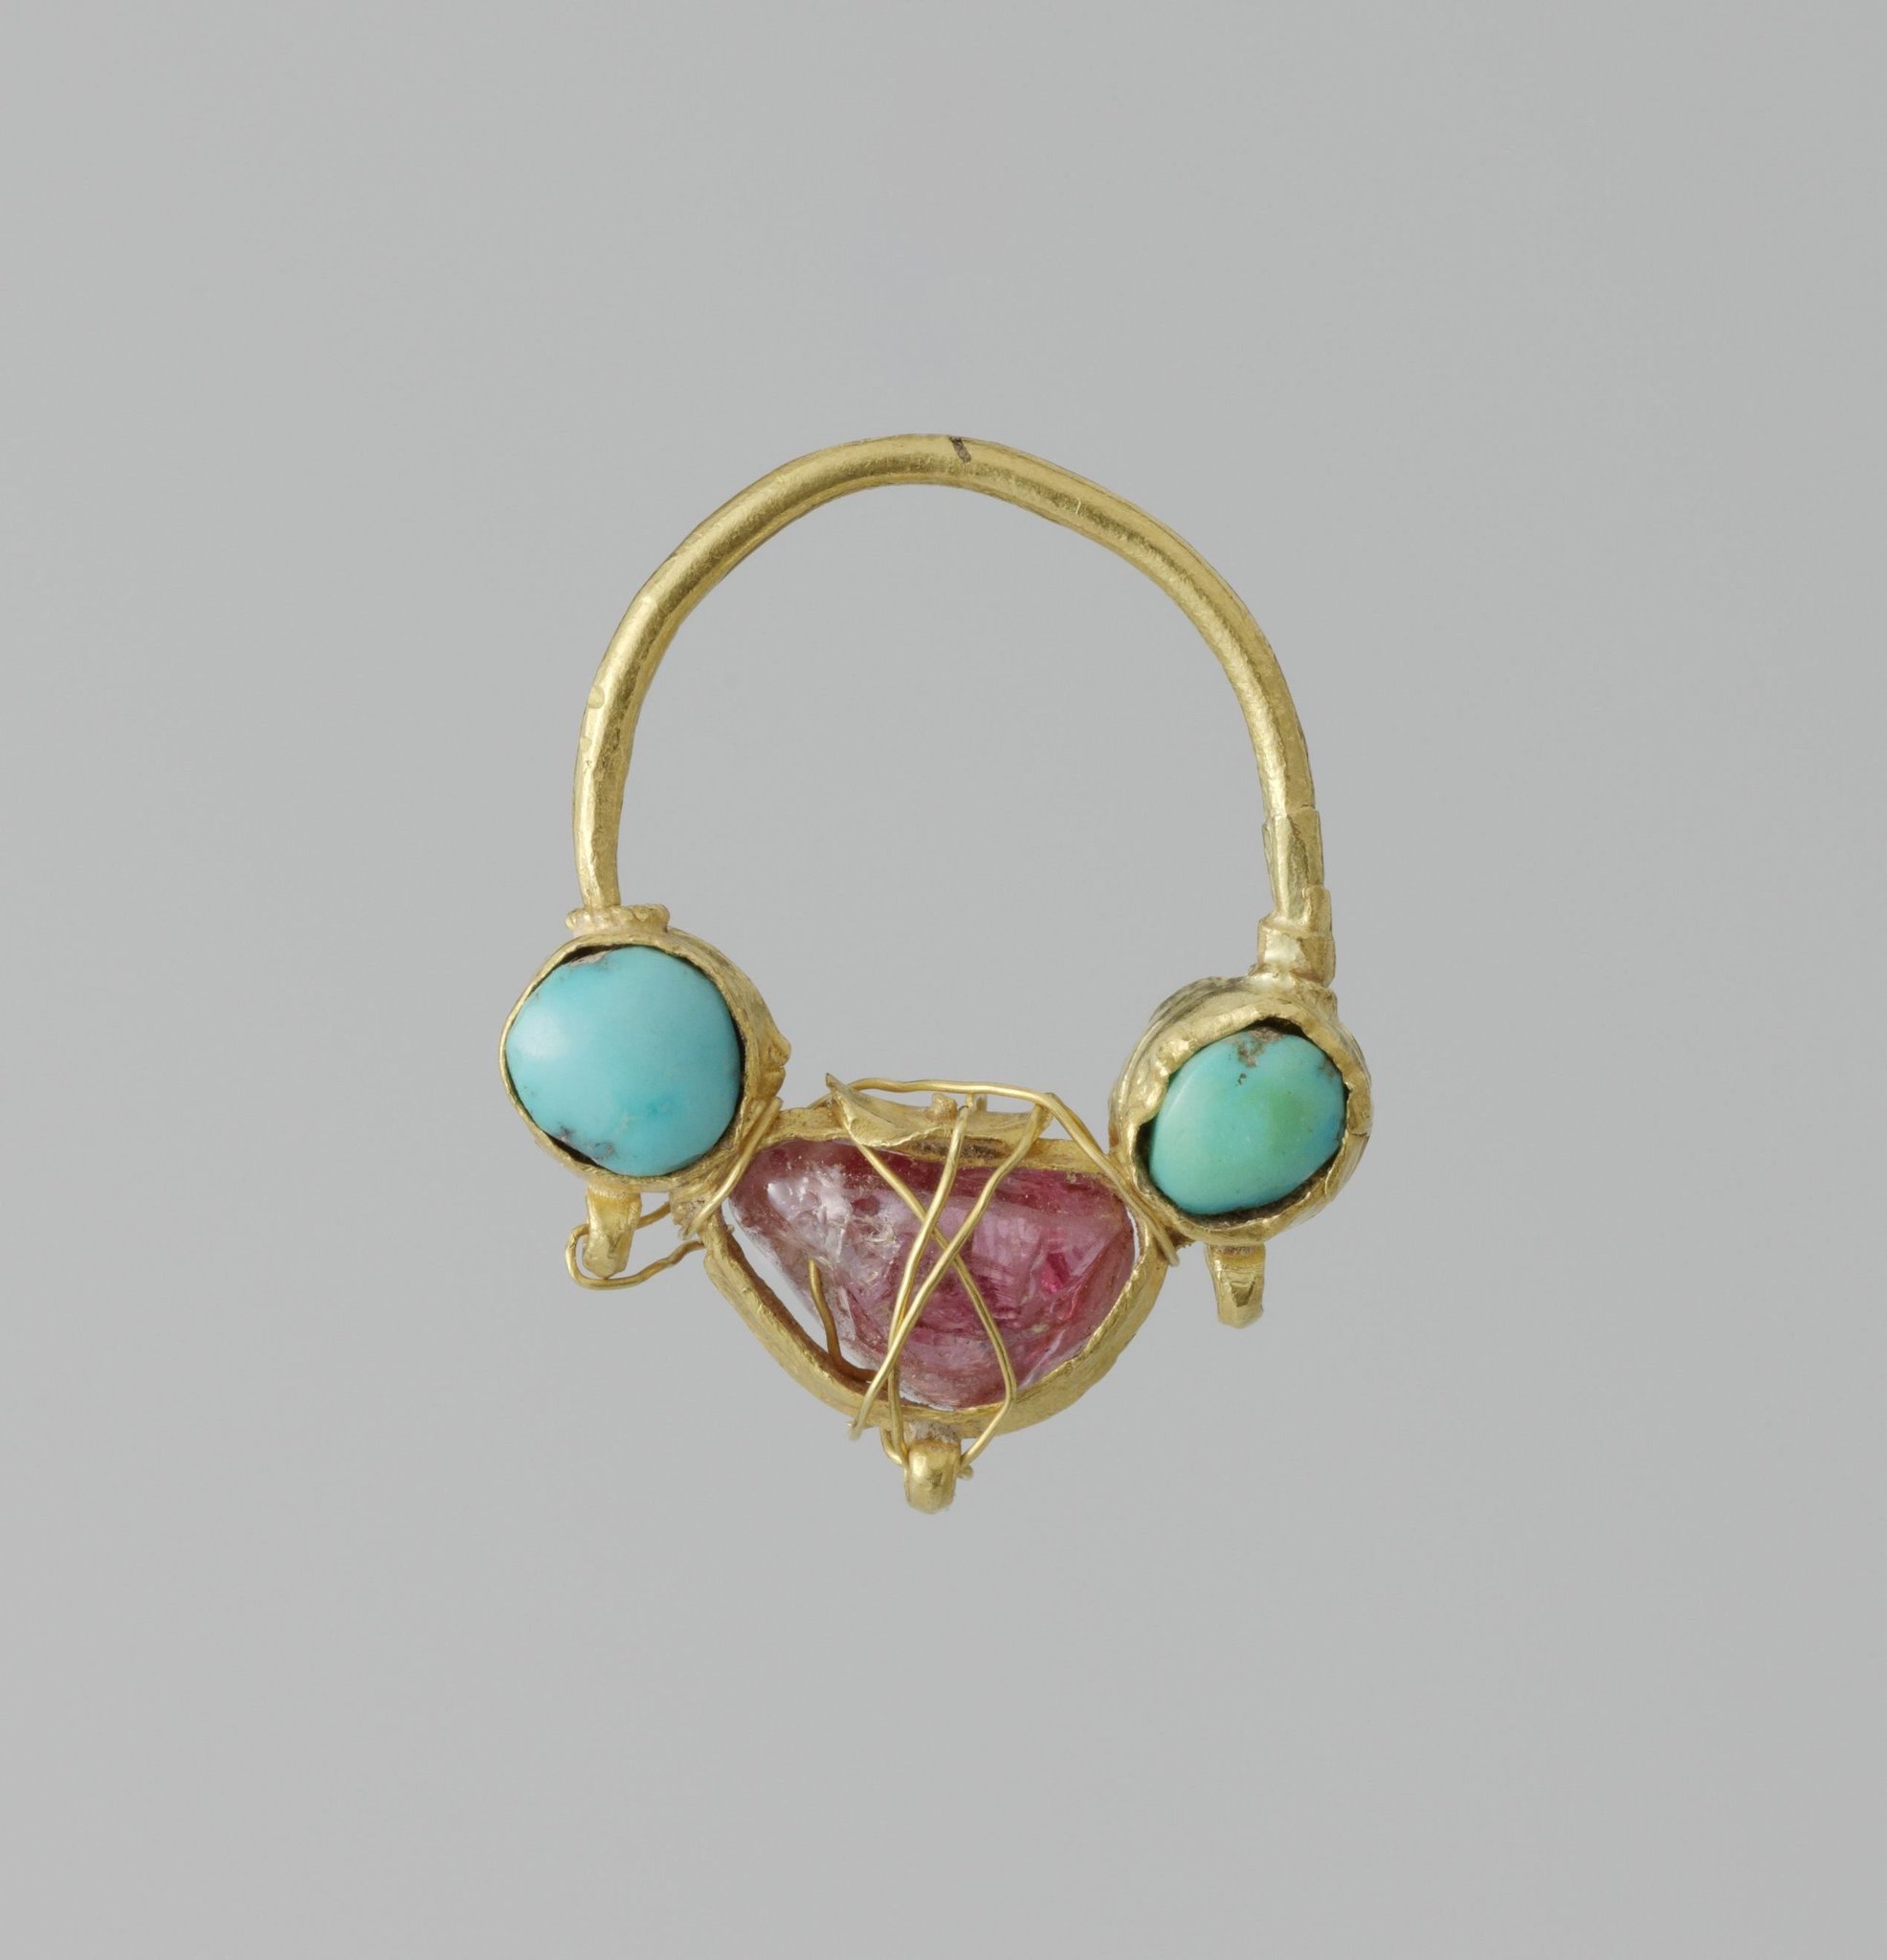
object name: ear ornament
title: Oorhanger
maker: Anonymous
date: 500-700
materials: gemstone, gold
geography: byzantium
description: Earring. Gold, amethyst, turquoise. Byzantine Empire, 7th century.